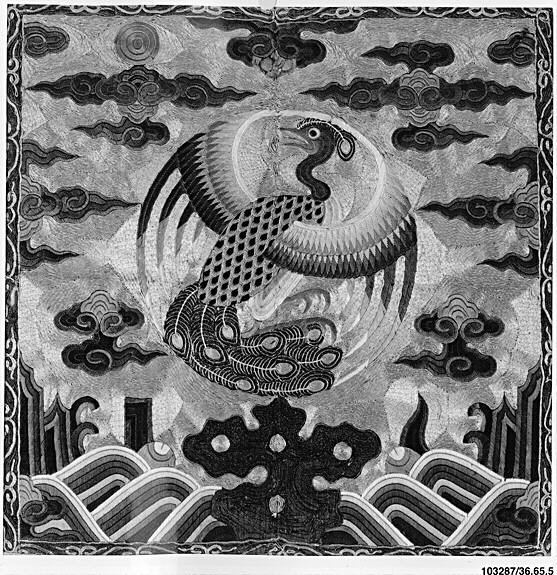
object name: rank badge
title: Rank Badge with Peacock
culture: chinese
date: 1701-1800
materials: feather, metal thread, silk, thread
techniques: embroidery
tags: peacocks